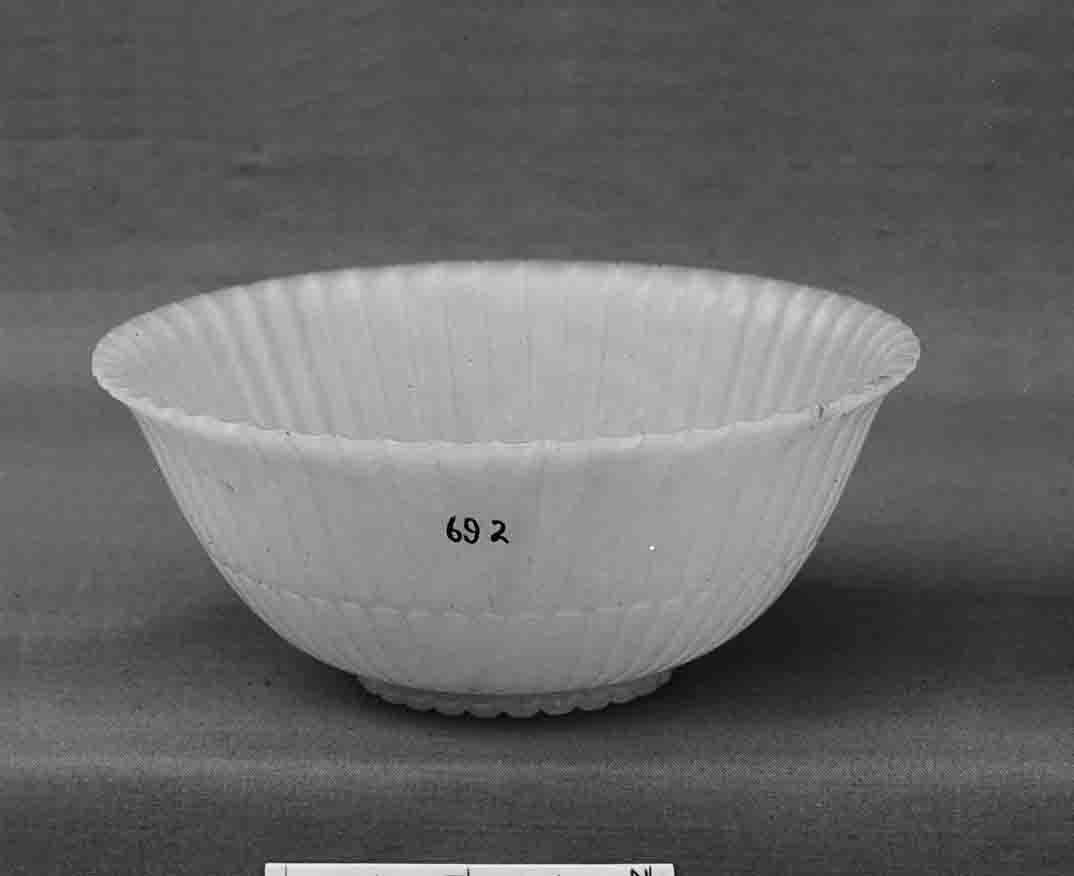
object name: one of pair of rice bowl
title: One of Pair of Rice Bowls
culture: chinese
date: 1736-1795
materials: jade